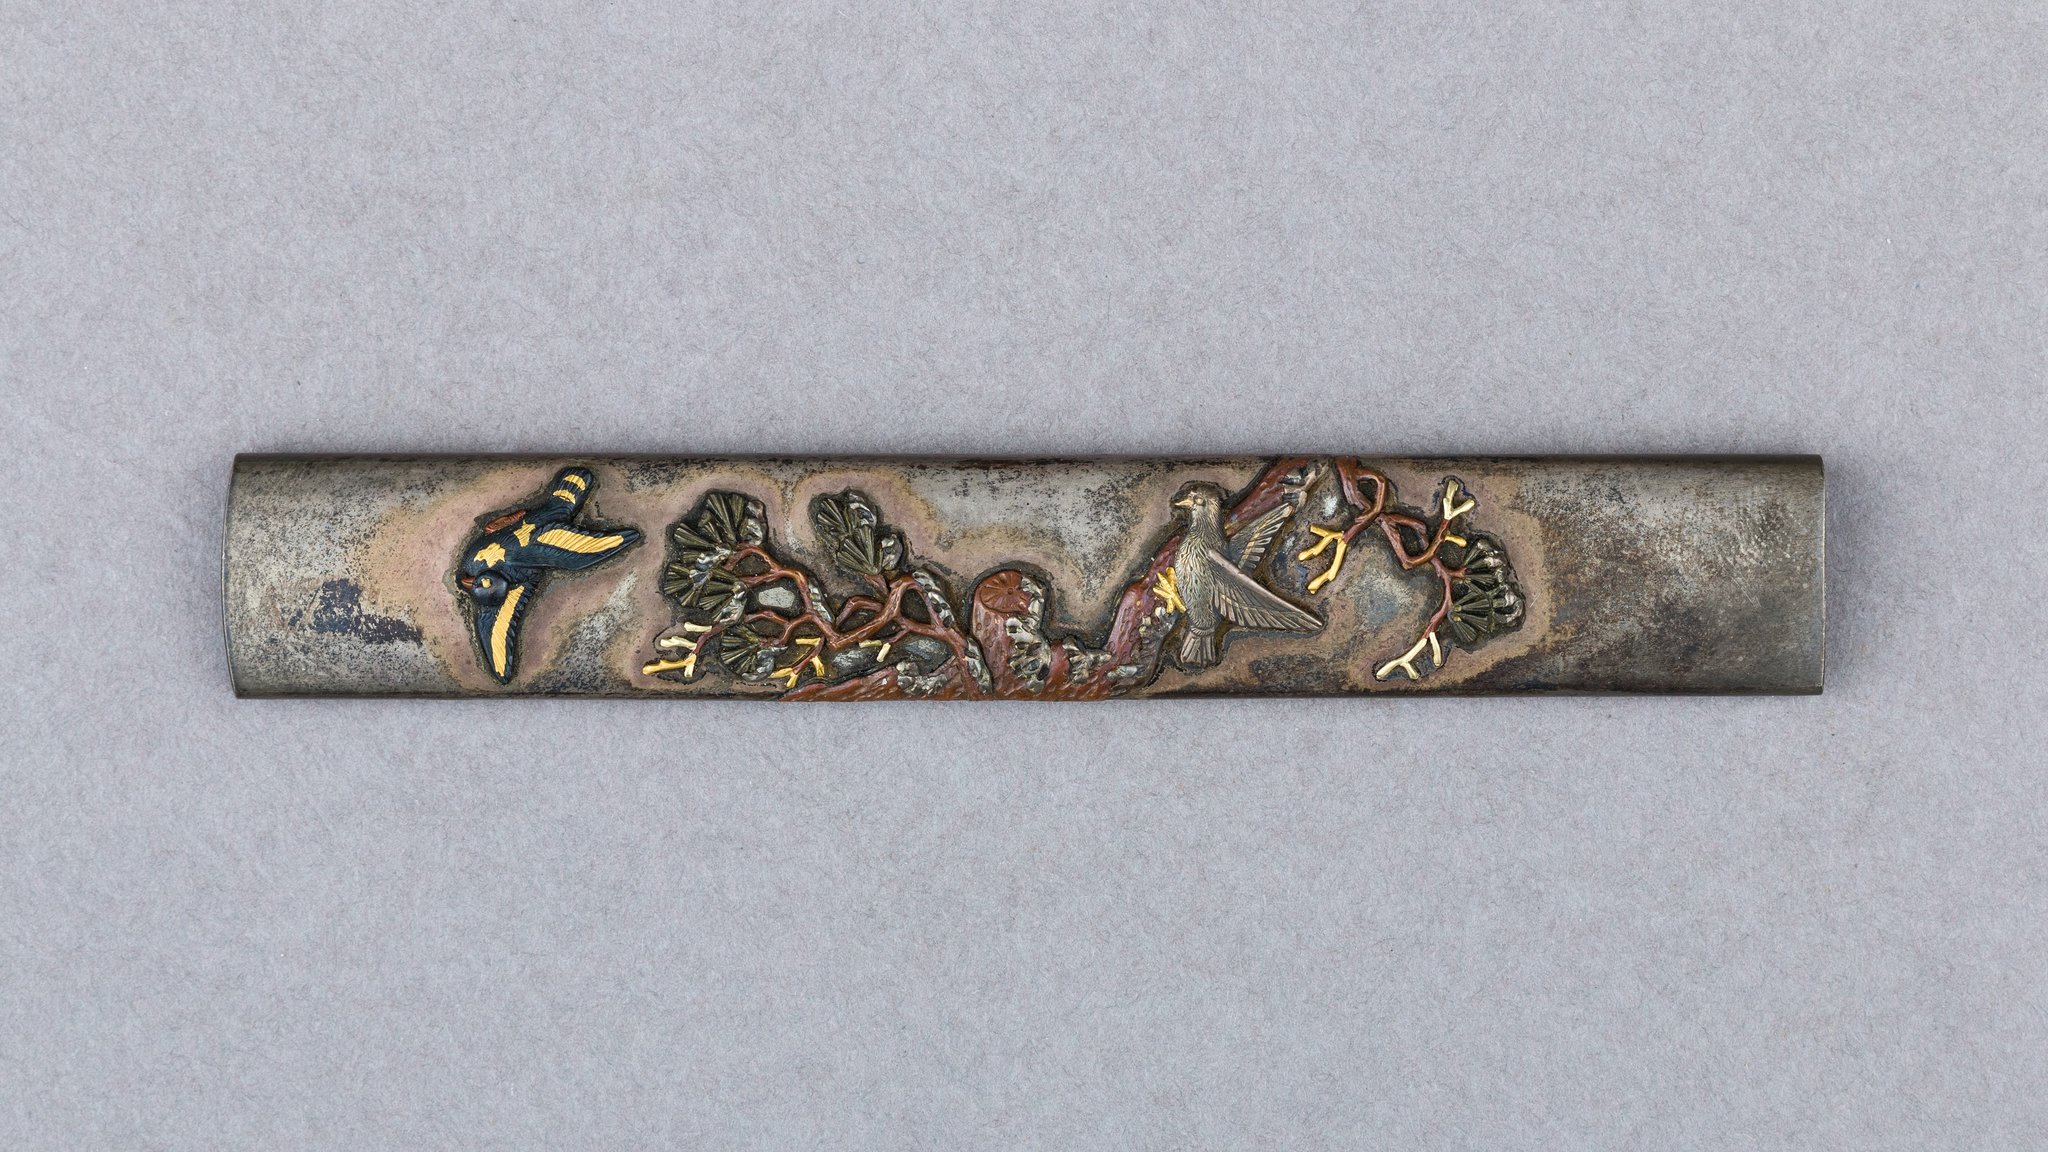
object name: knife handle kozuka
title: Knife Handle (Kozuka)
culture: japanese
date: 1615-1868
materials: copper, gold alloy, silver alloy, gold, silver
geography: japan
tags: birds,trees